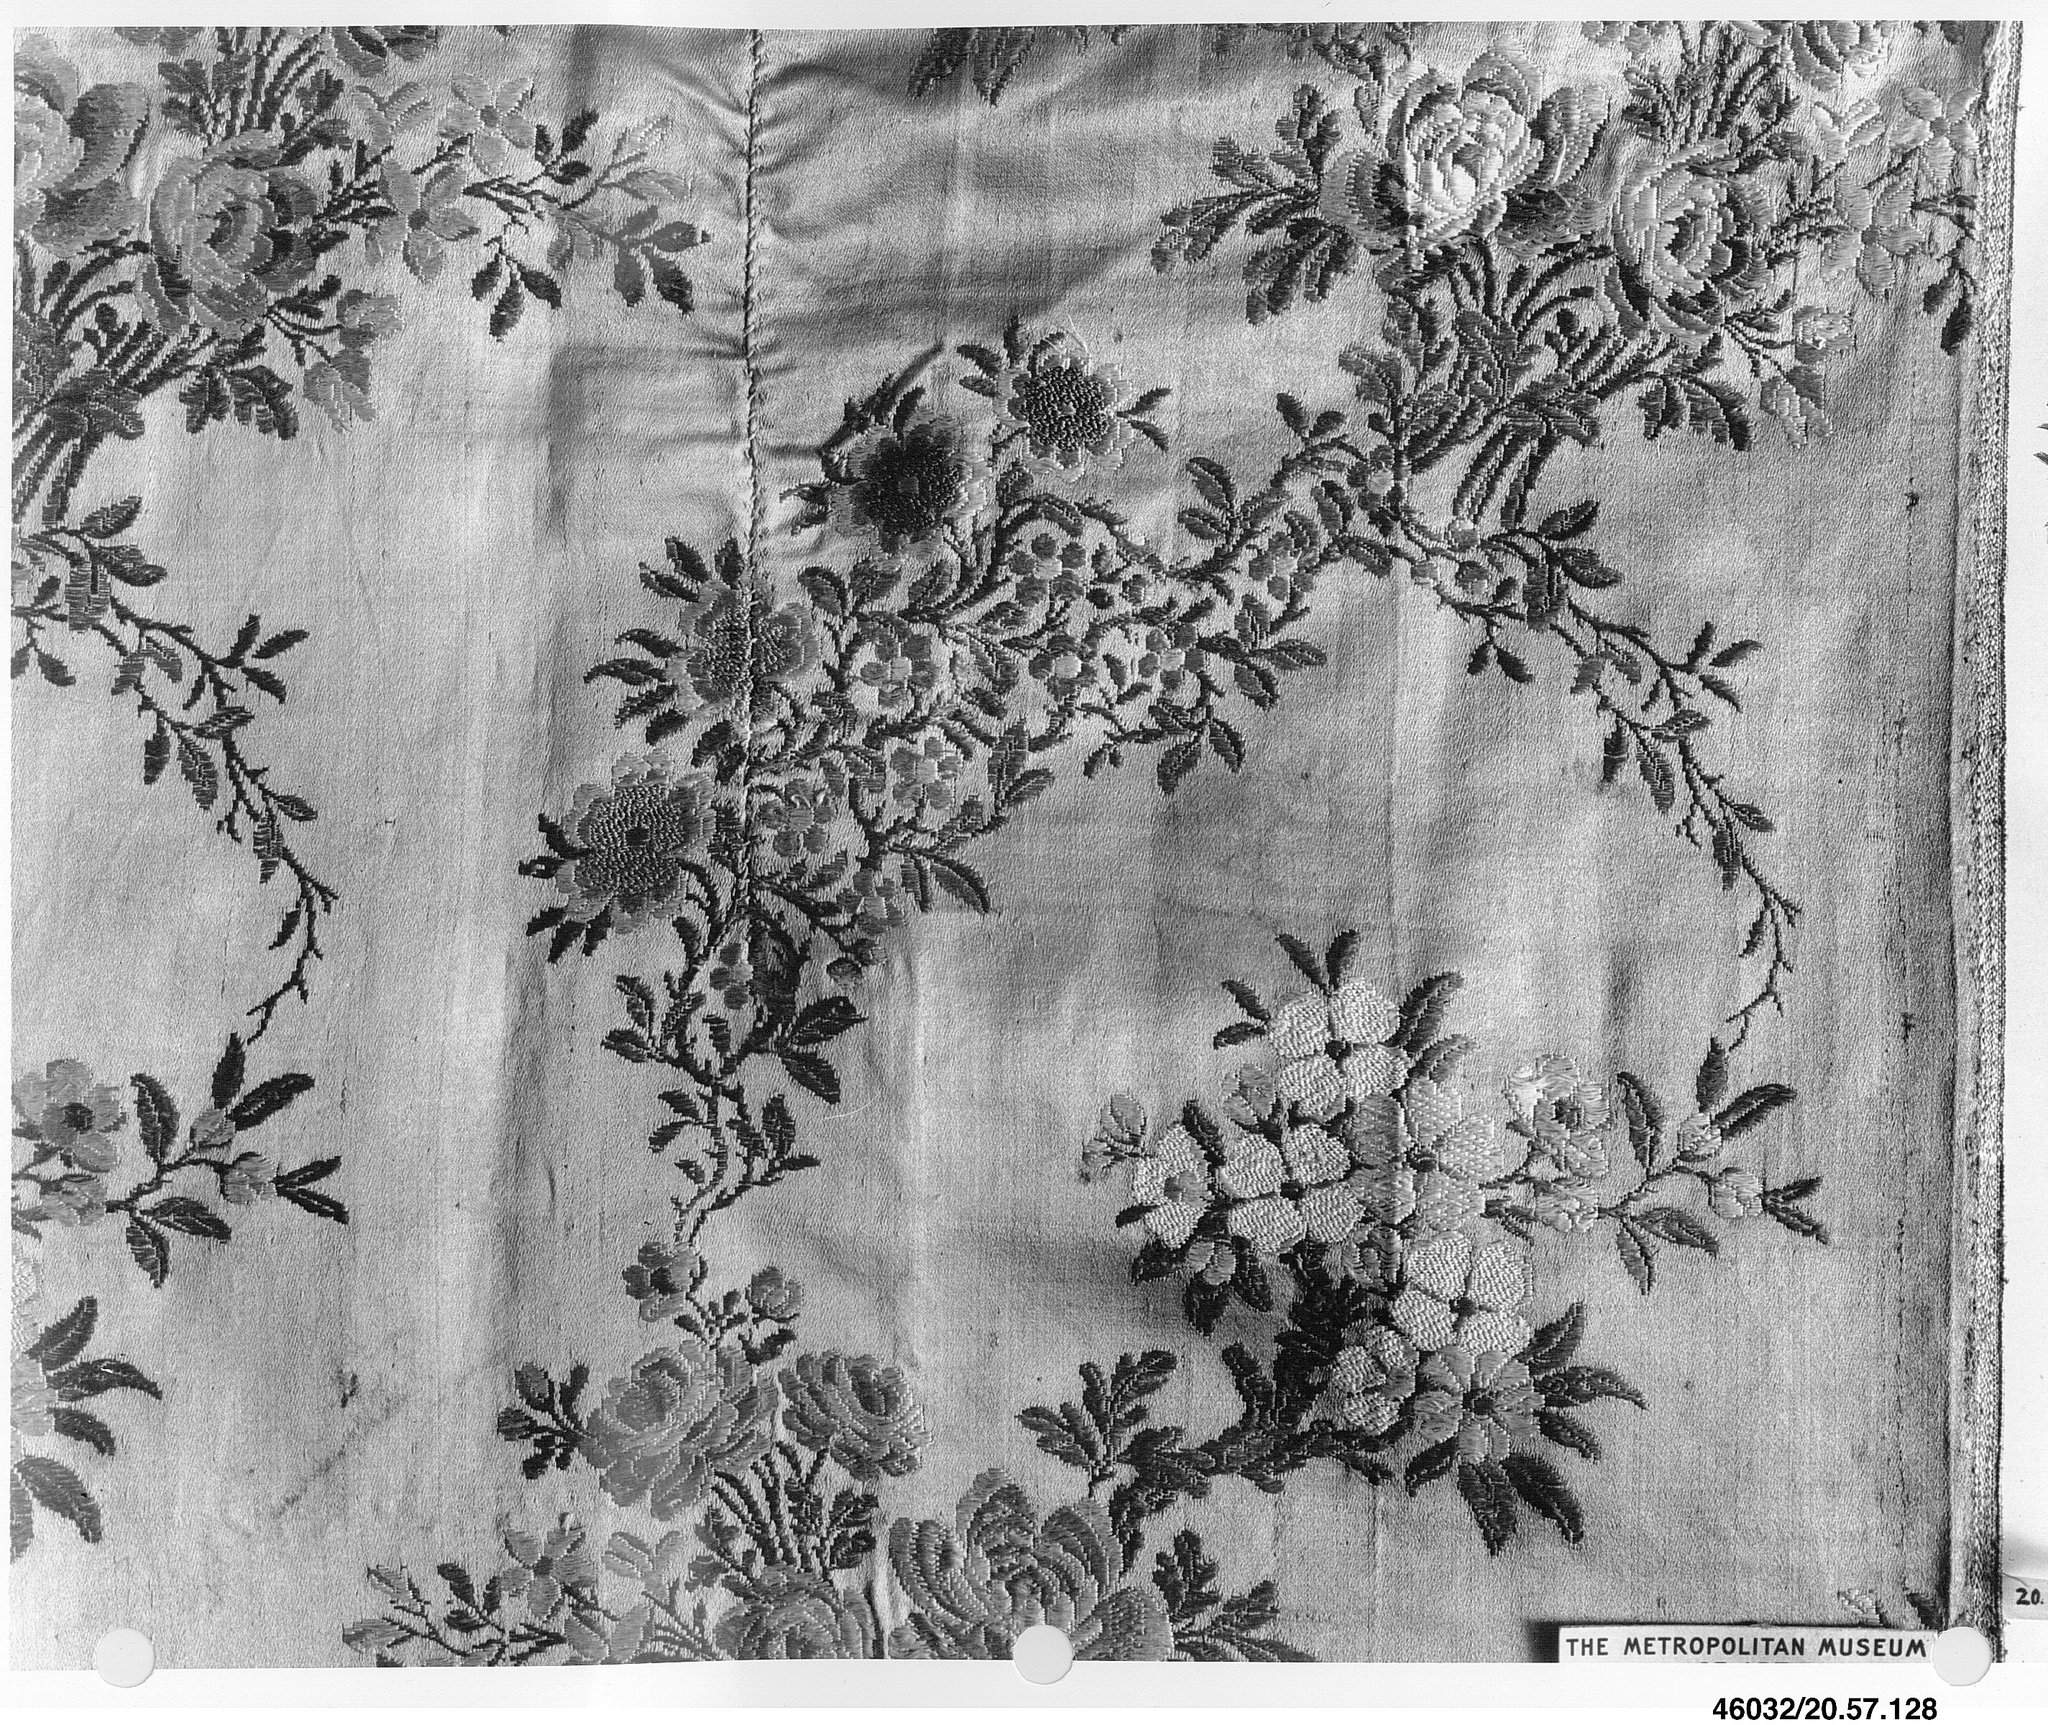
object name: piece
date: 1750-1760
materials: silk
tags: flowers,leaves